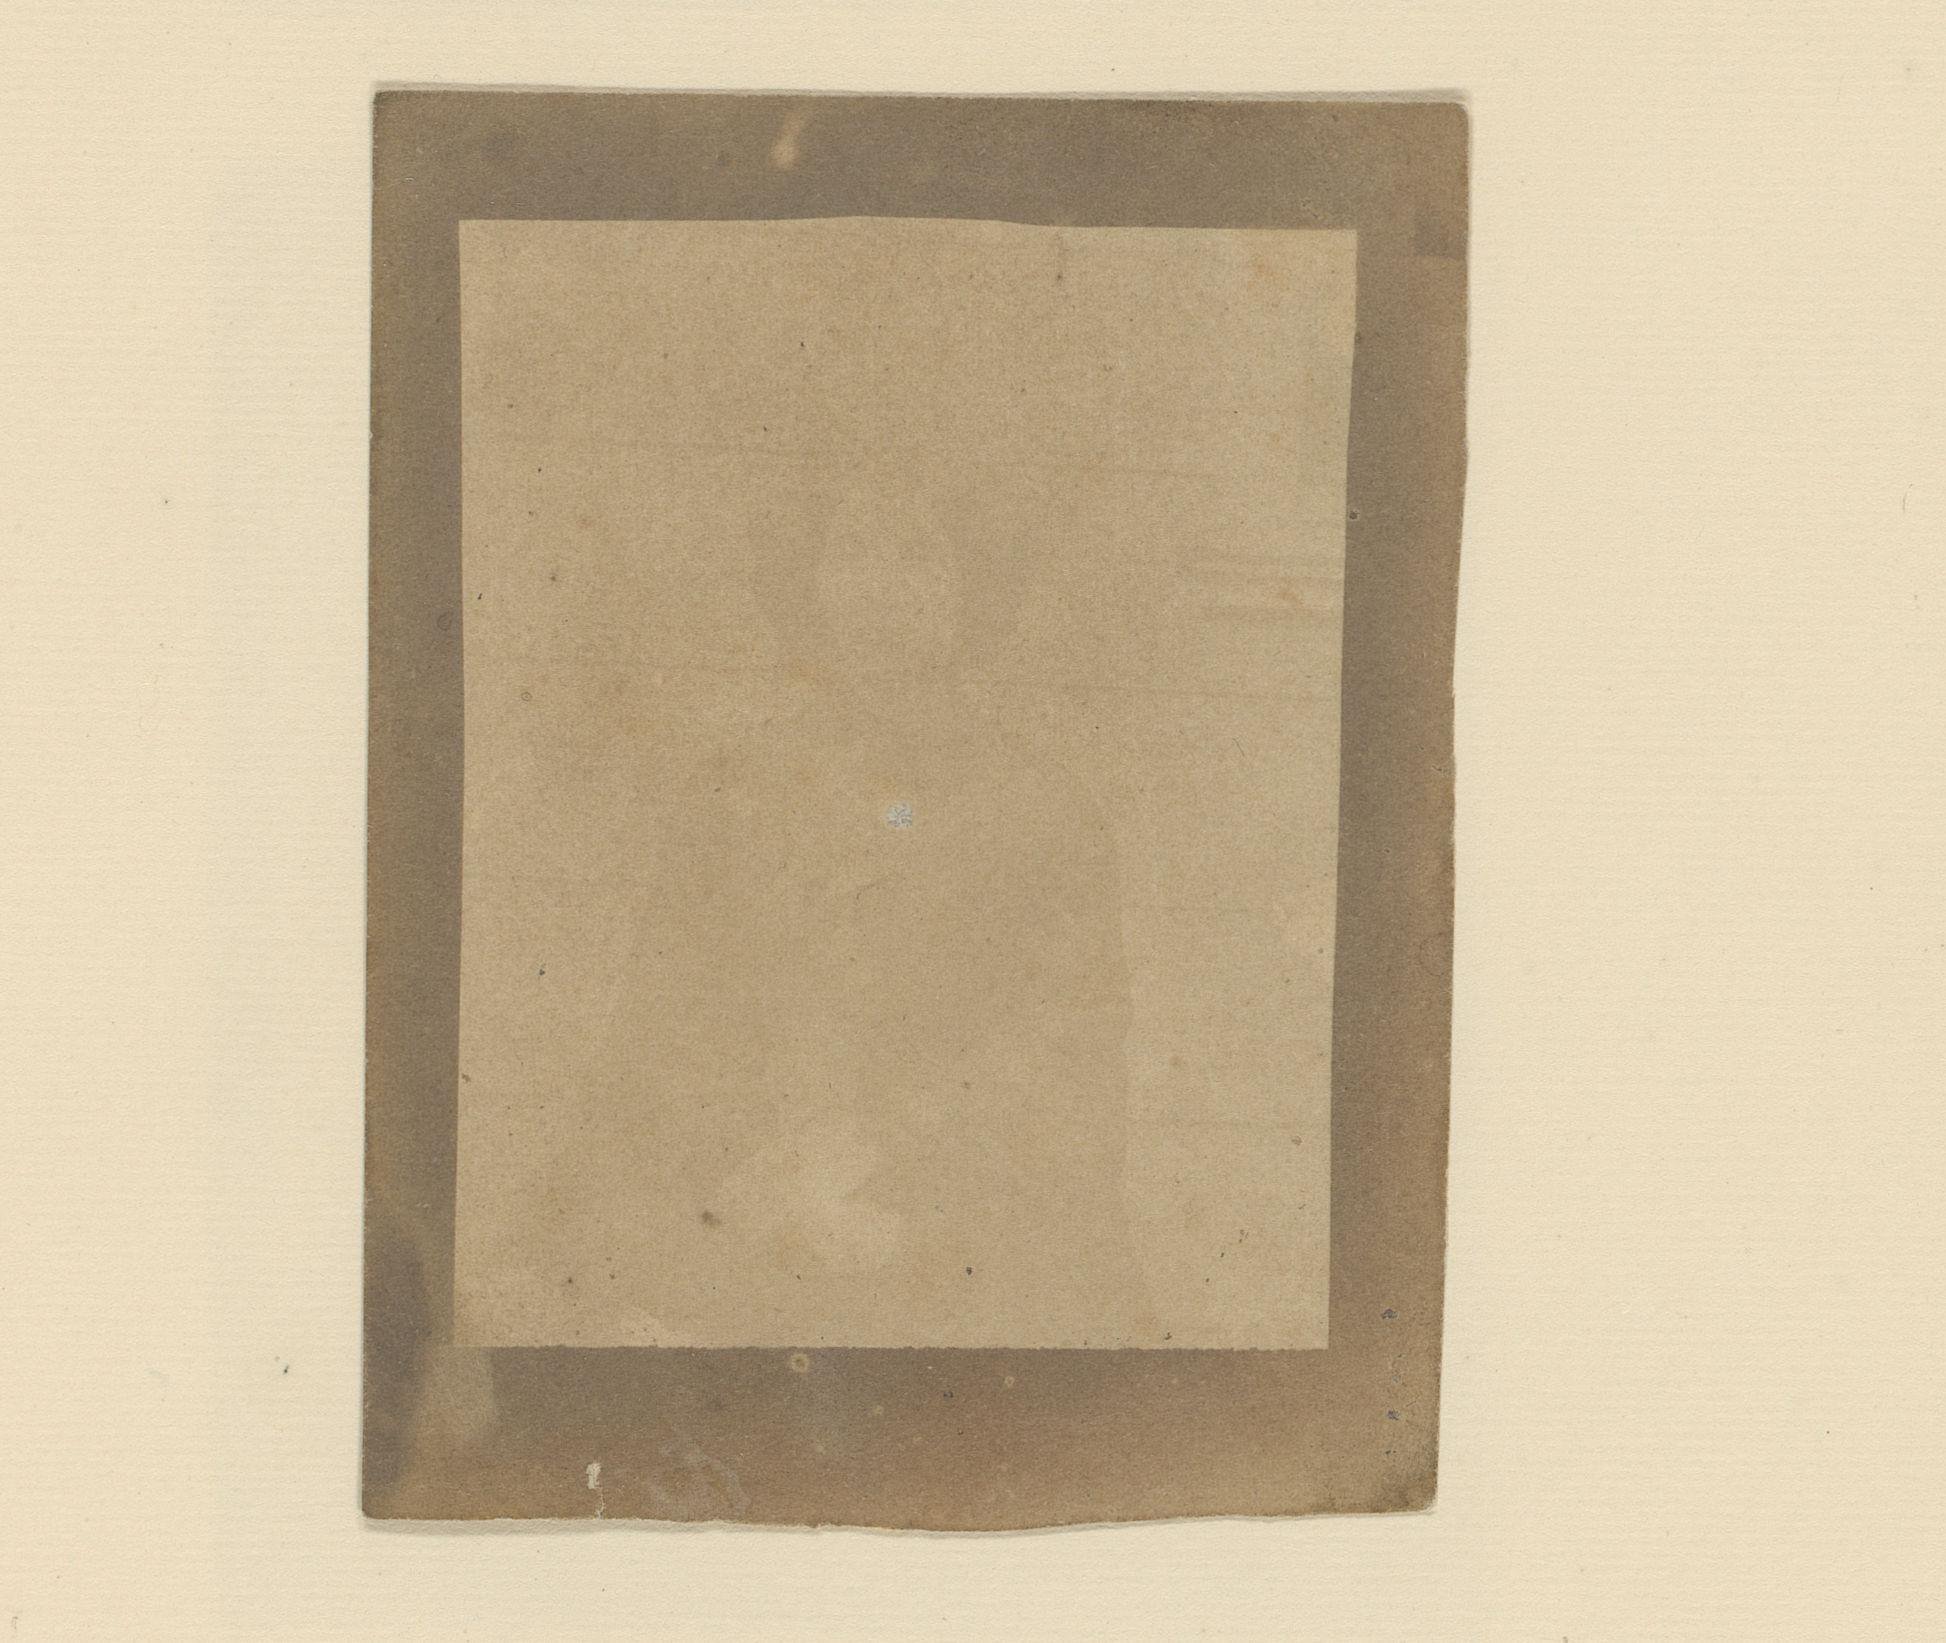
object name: photograph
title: Portret van een oudere vrouw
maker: eduard isaac asser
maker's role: amateurfotograaf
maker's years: 1809-1894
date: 1846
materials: cardboard, paper, photographic support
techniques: salted paper print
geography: amsterdam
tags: historical persons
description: de vrouw is vermoedelijk de moeder van de fotograaf